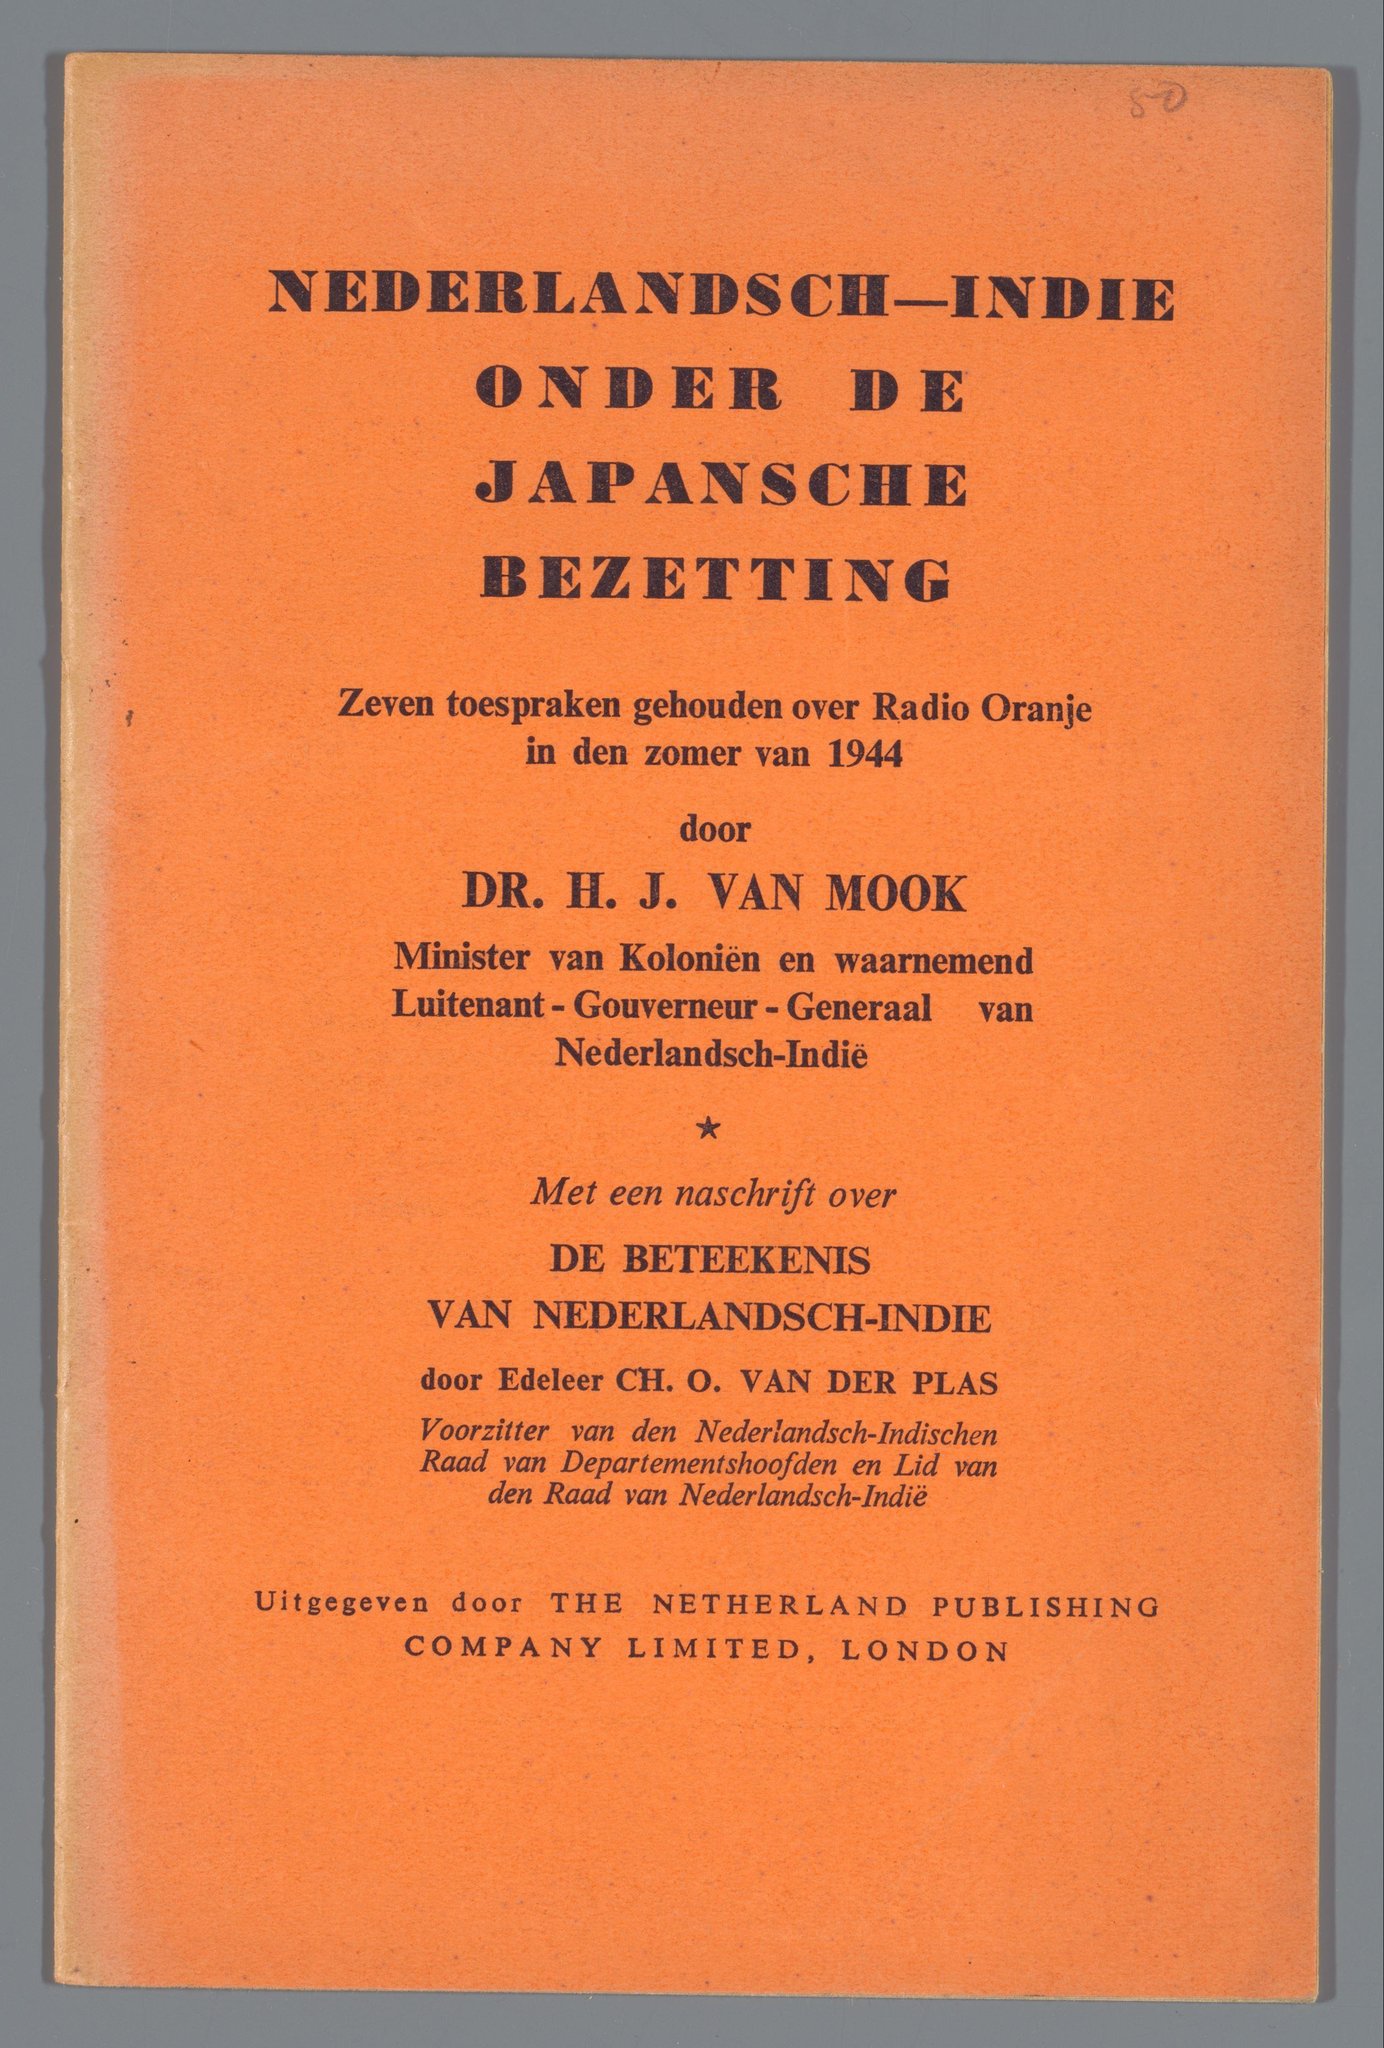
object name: brochure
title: Nederlandsch-Indië onder de Japansche bezetting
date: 1944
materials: paper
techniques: printing, stapling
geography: london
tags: france, hubertus johannes van mook, charles olke van der plas, dutch east indies, the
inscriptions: title: ‘NEDERLANDSCH-INDIË / ONDER DE / JAPANSCHE / BEZETTING/ Zeven toespraken gehuden over Radio Oranje / den zomer van 1944 / door Dr. H.J. VAN MOOK / Met naschrift over / DE BETEEKENIS VAN NEDERLANDSCH-INDIË / door Edeleer CH.O. VAN DER PLAS’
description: De heer H.J. van Mook was in 1944 minister van koloniën en waarnemend luitenant-gouverneur-generaal van Nederlands-Indië. Ch.O. van der Plas was in 1944 voorzitter van de Nederlands-Indische raad van Departementshoofden en lid van de Raad van Nederlands-Indië. In 1942 werd hij naar Australië gezonden om aldaar van Mook te assisteren bij de continuering van de Nederlands-Indische regering.